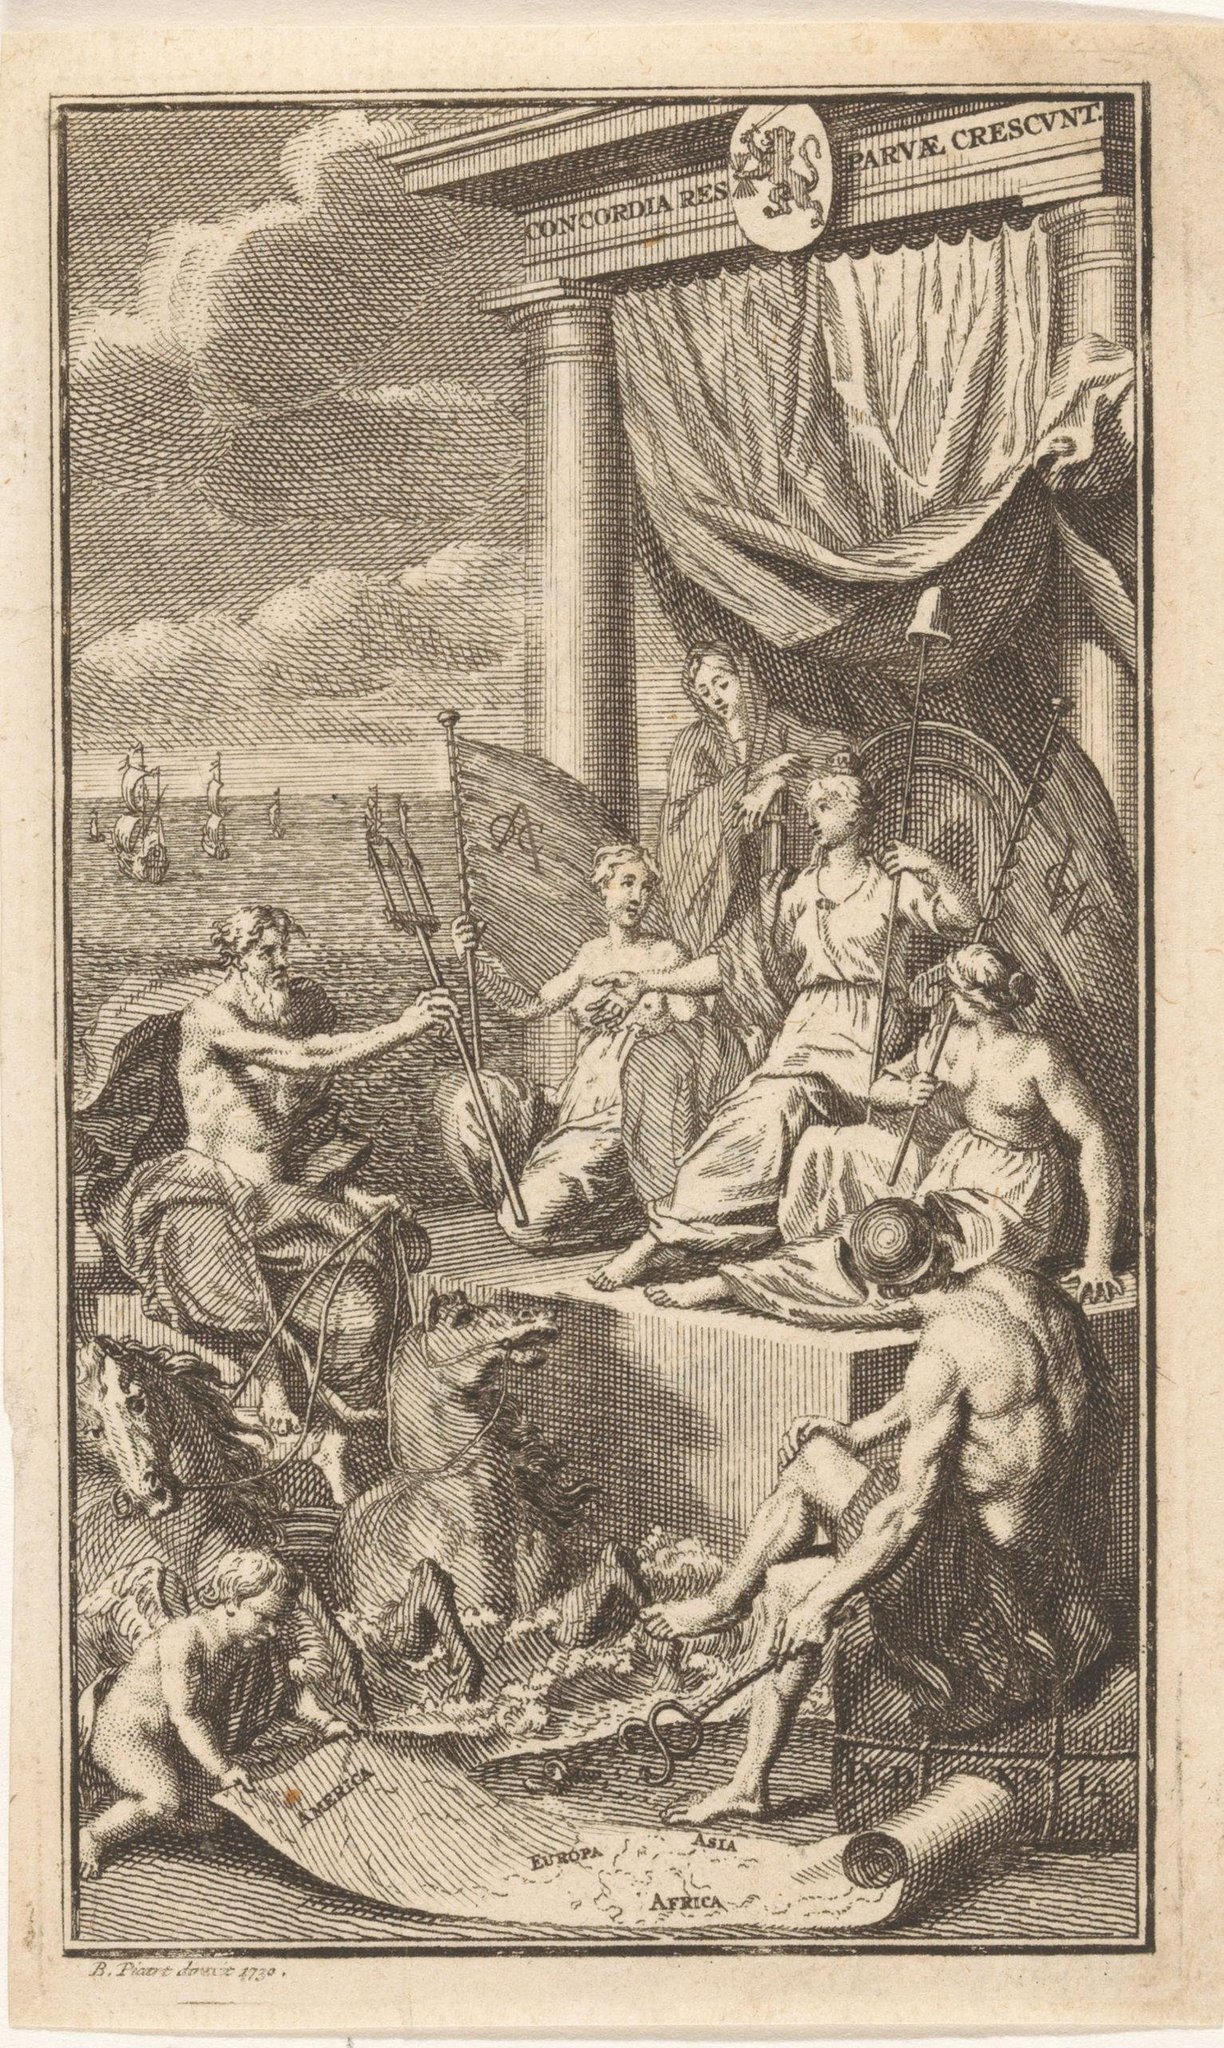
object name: print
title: Allegorie op de macht van de Republiek der Zeven Verenigde Nederlanden als zeemogenheid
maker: bernard picart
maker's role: draughtsman, print maker, publisher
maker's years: 1673-1733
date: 1730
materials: paper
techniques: engraving, etching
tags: (story of) neptune (poseidon), personifications of countries, nations, states, districts, etc., (story of) mercury (hermes), map of the world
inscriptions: collector's mark: Lugt 2228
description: Neptunus schenkt zijn drietand, die symbool staat voor de overheersing op de wereldzeeën, aan de personificatie van de Republiek der Zeven Verenigde Nederlanden. Zij houdt in de hand een lans met vrijheidshoed en wordt omringd door de personificaties van de Oost-Indische Compagnie (VOC) en de West-Indische Compagnie (WIC). Rechts wijst Mercurius met zijn caduceus op de wereldkaart die door een putto wordt uitgerold. In de ondermarge een vierregelige Franse tekst.